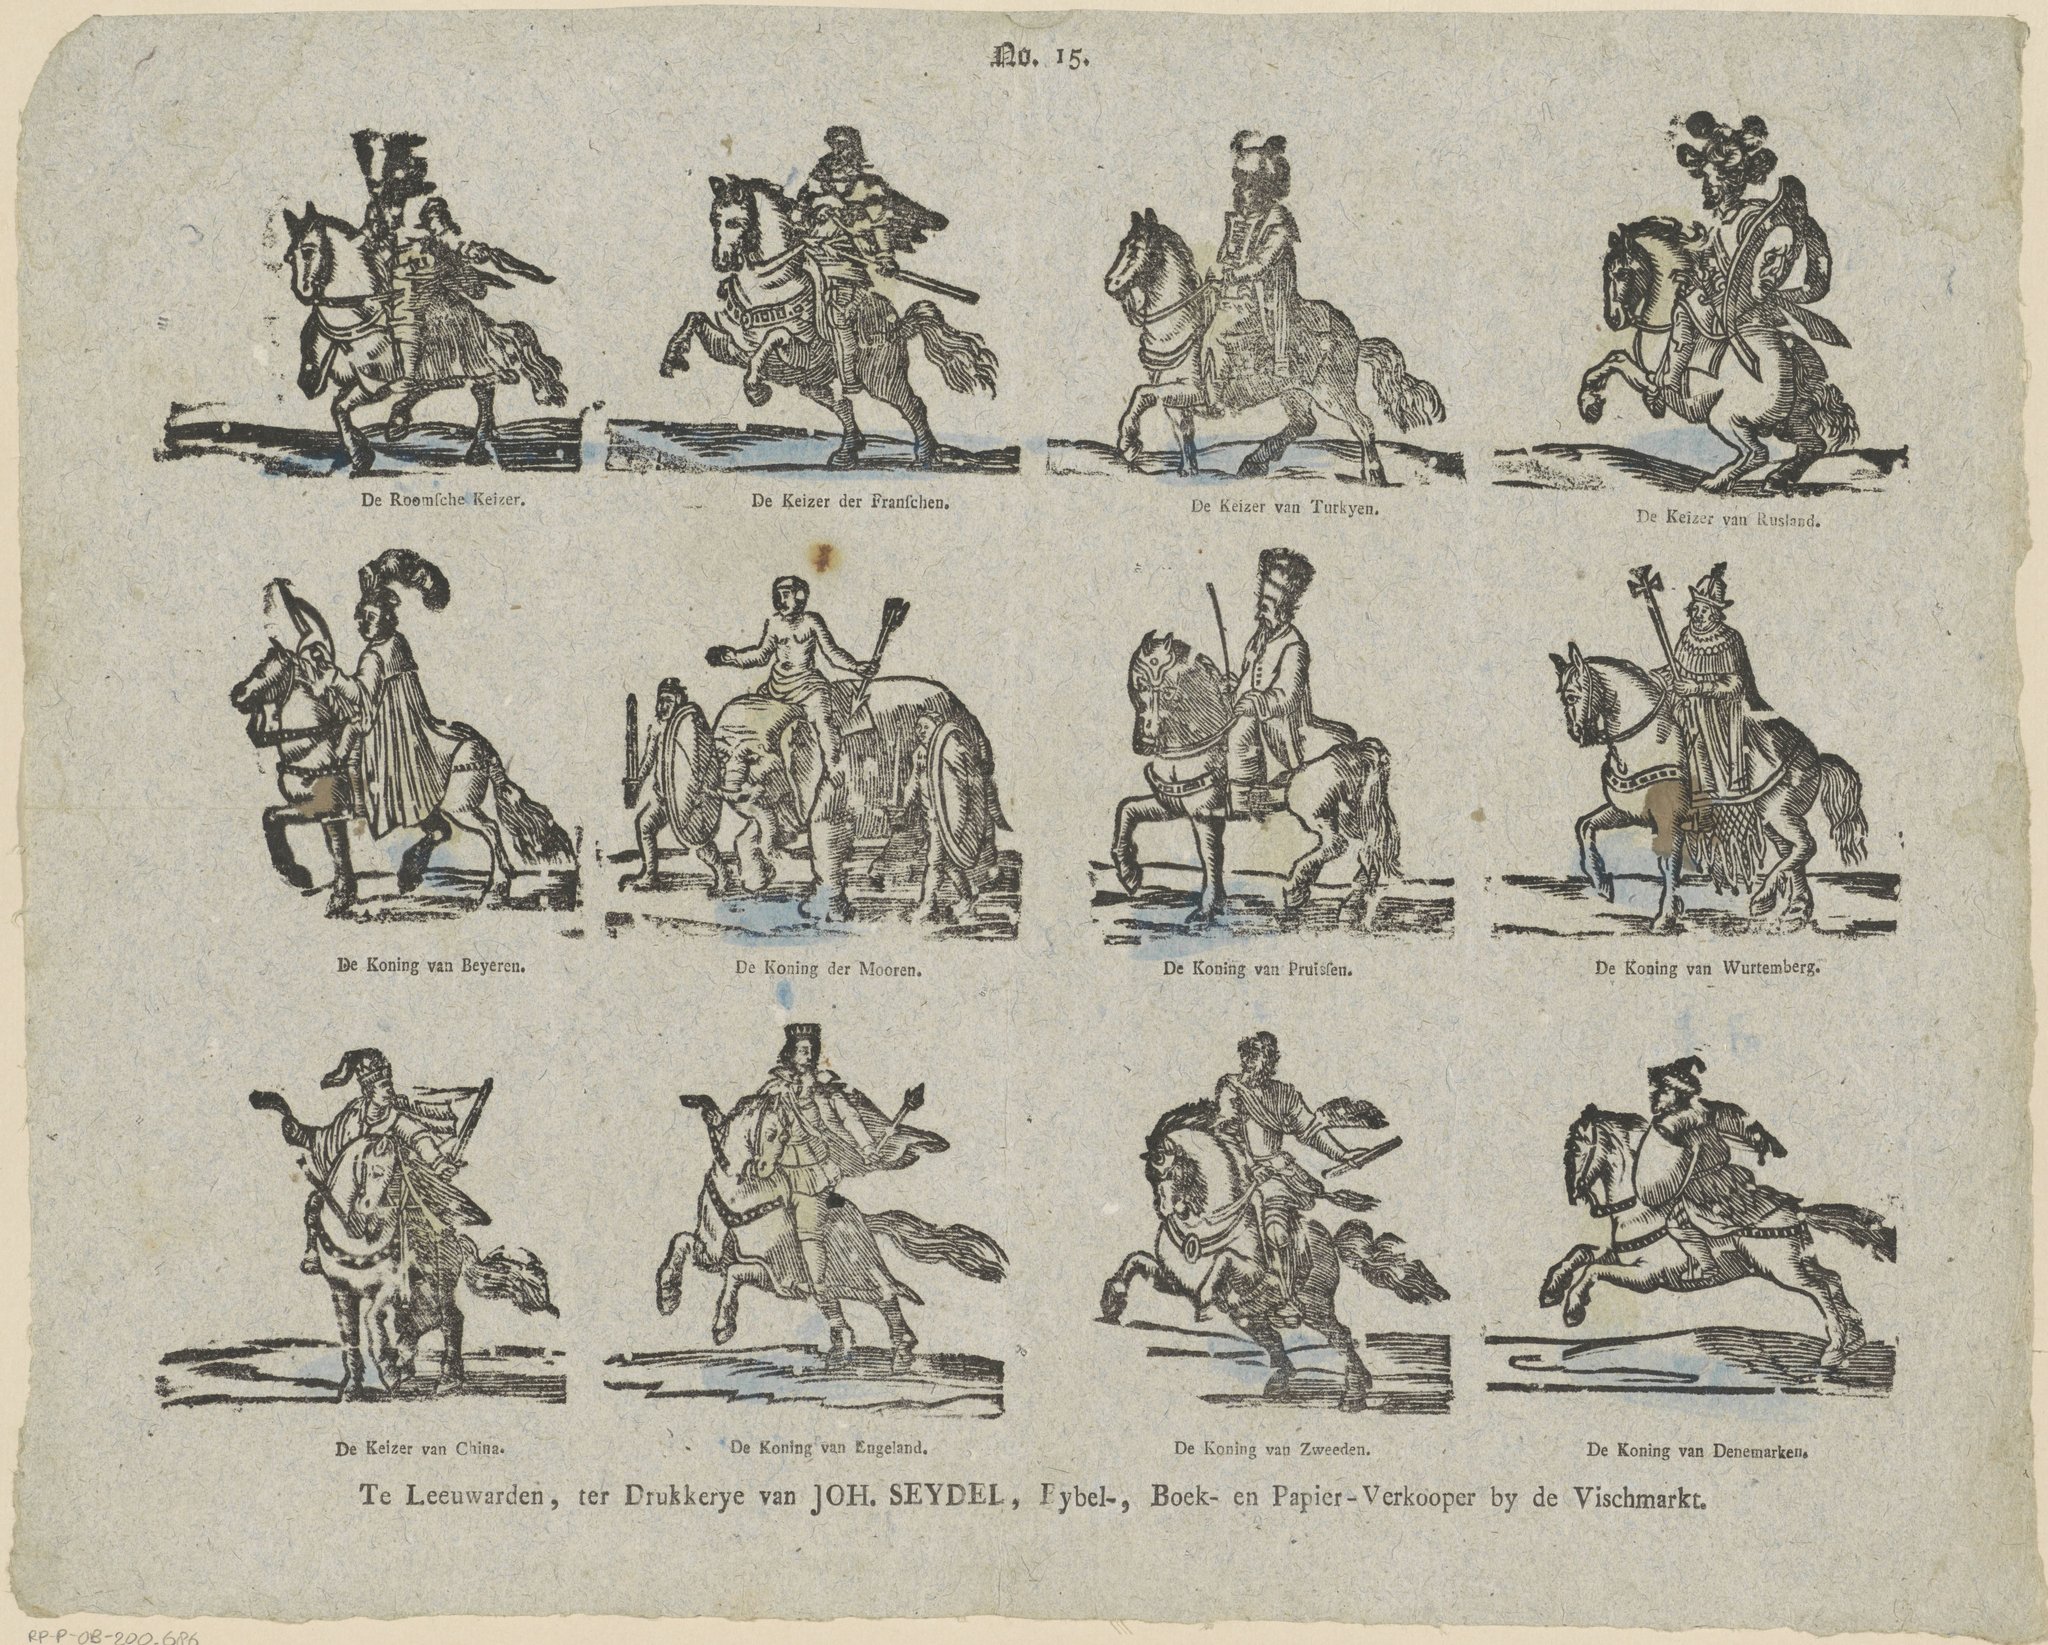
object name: print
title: Keizers en koningen te paard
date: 1776-1813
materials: paper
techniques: colour, letterpress printing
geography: leeuwarden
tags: equestrian state-portrait, trunked animals (with name) (+ animal riding), emperor, trunked animals: elephant, nobility and patriciate; chivalry, knighthood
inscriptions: collector's mark: Lugt 2760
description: Blad met 12 voorstellingen van keizers en koningen te paard en de koning der Mooren op een olifant. Onder elke afbeelding een onderschrift. Genummerd midden boven: No. 15.